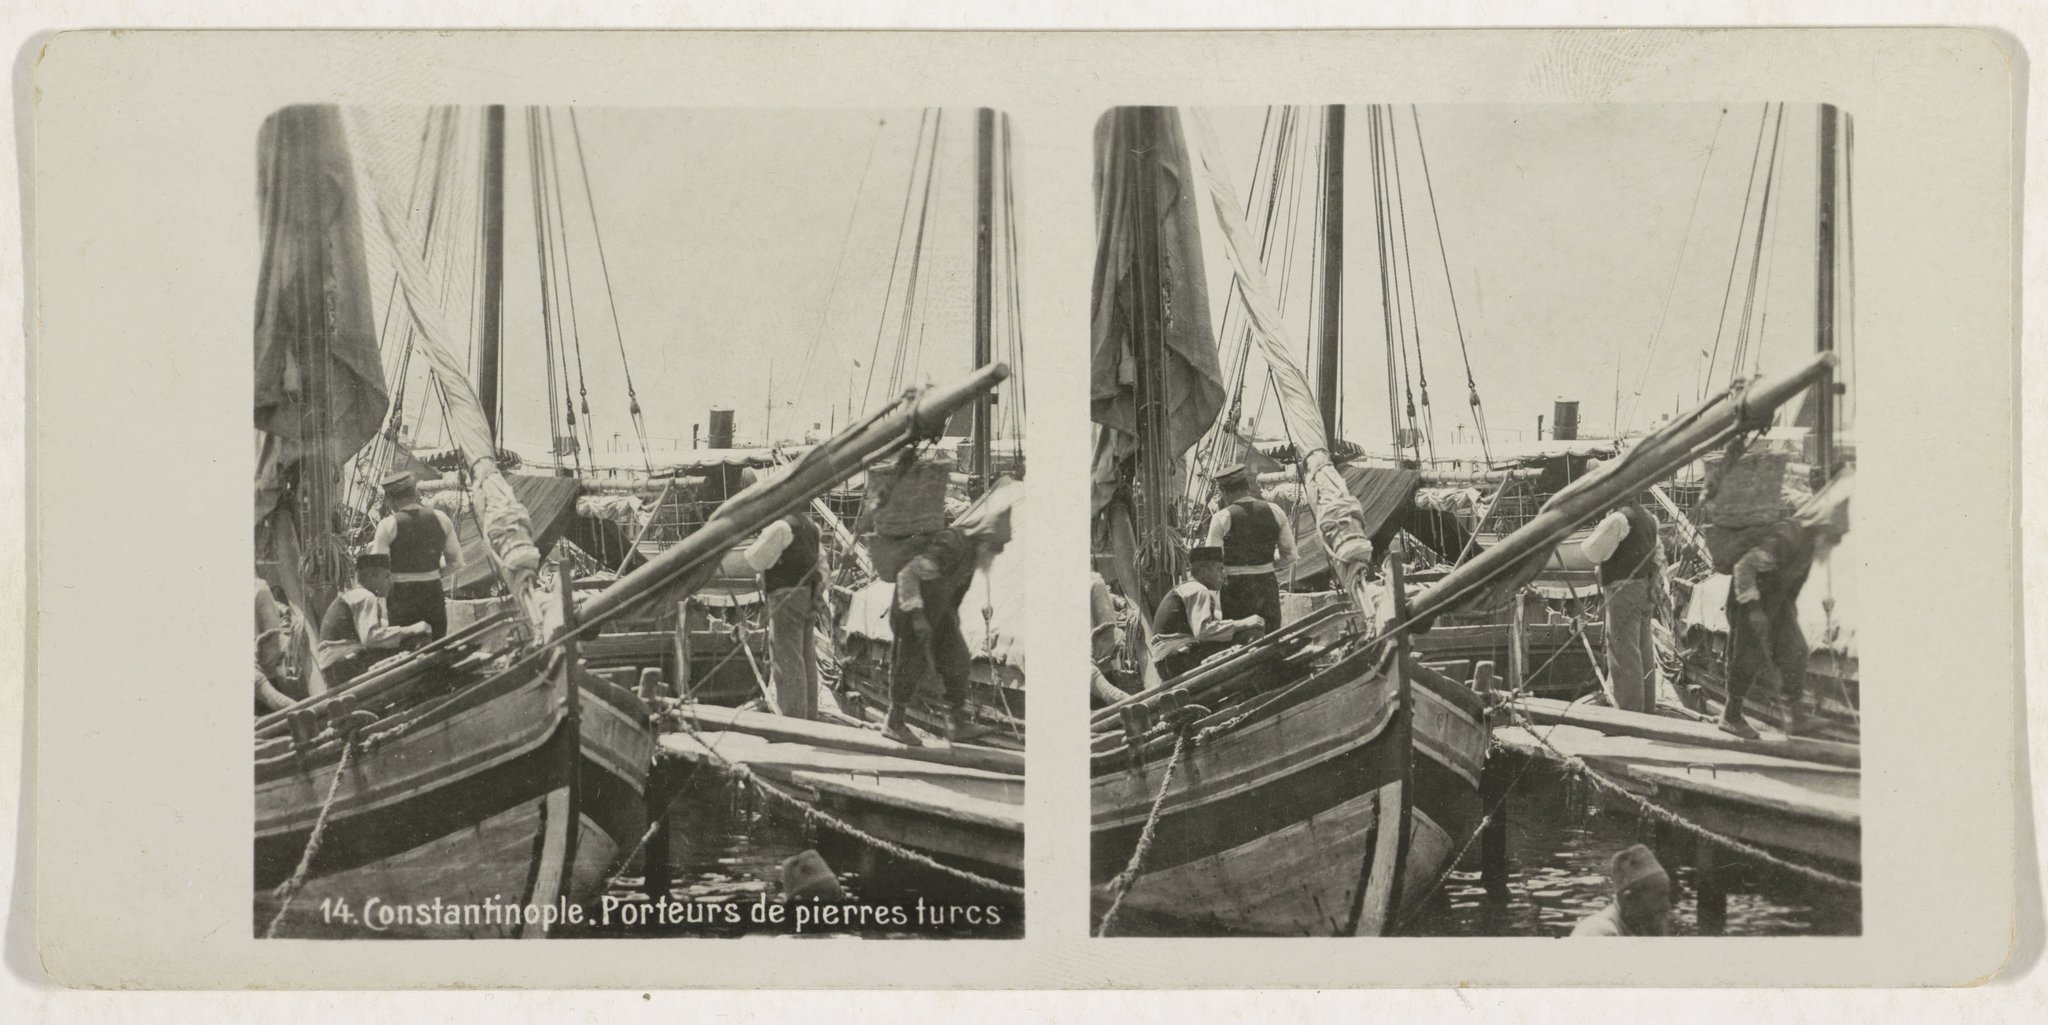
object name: stereograph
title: Constantinople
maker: Anonymous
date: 1903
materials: paper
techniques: gelatin silver print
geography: haarlem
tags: harbour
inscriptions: number: ‘14.’, address: ‘Parklaan 49/ HAARLEM/ (Holland)’, monogram, inscription: ‘Deze stereo-foto's worden in den handel gebracht en en gros en/ en détail verkocht door de ......... (...)’, inscription: ‘Déposée.’